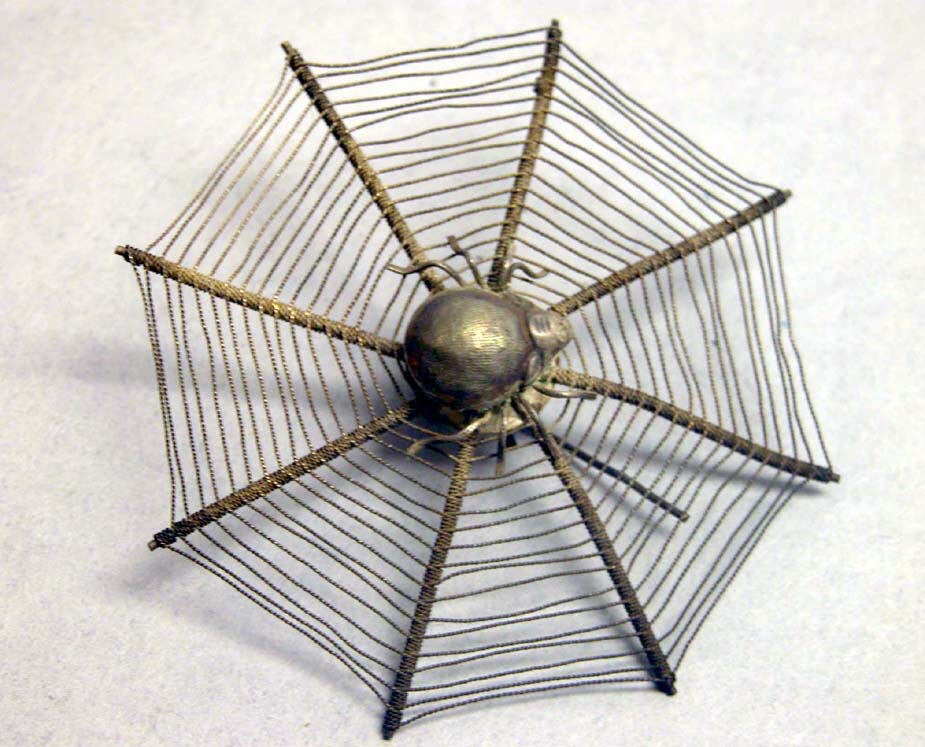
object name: hair ornament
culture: chinese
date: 1368-1699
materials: silver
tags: insects